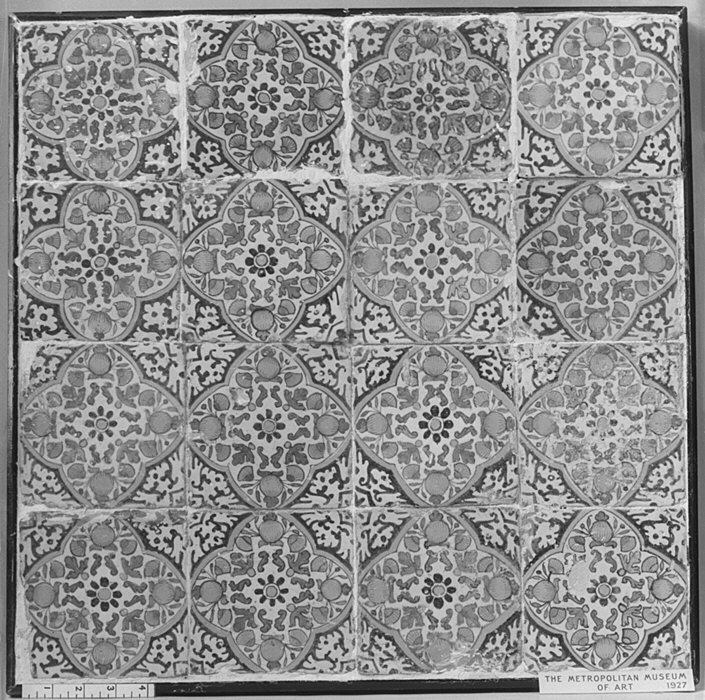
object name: tile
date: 1601-1625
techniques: glazing